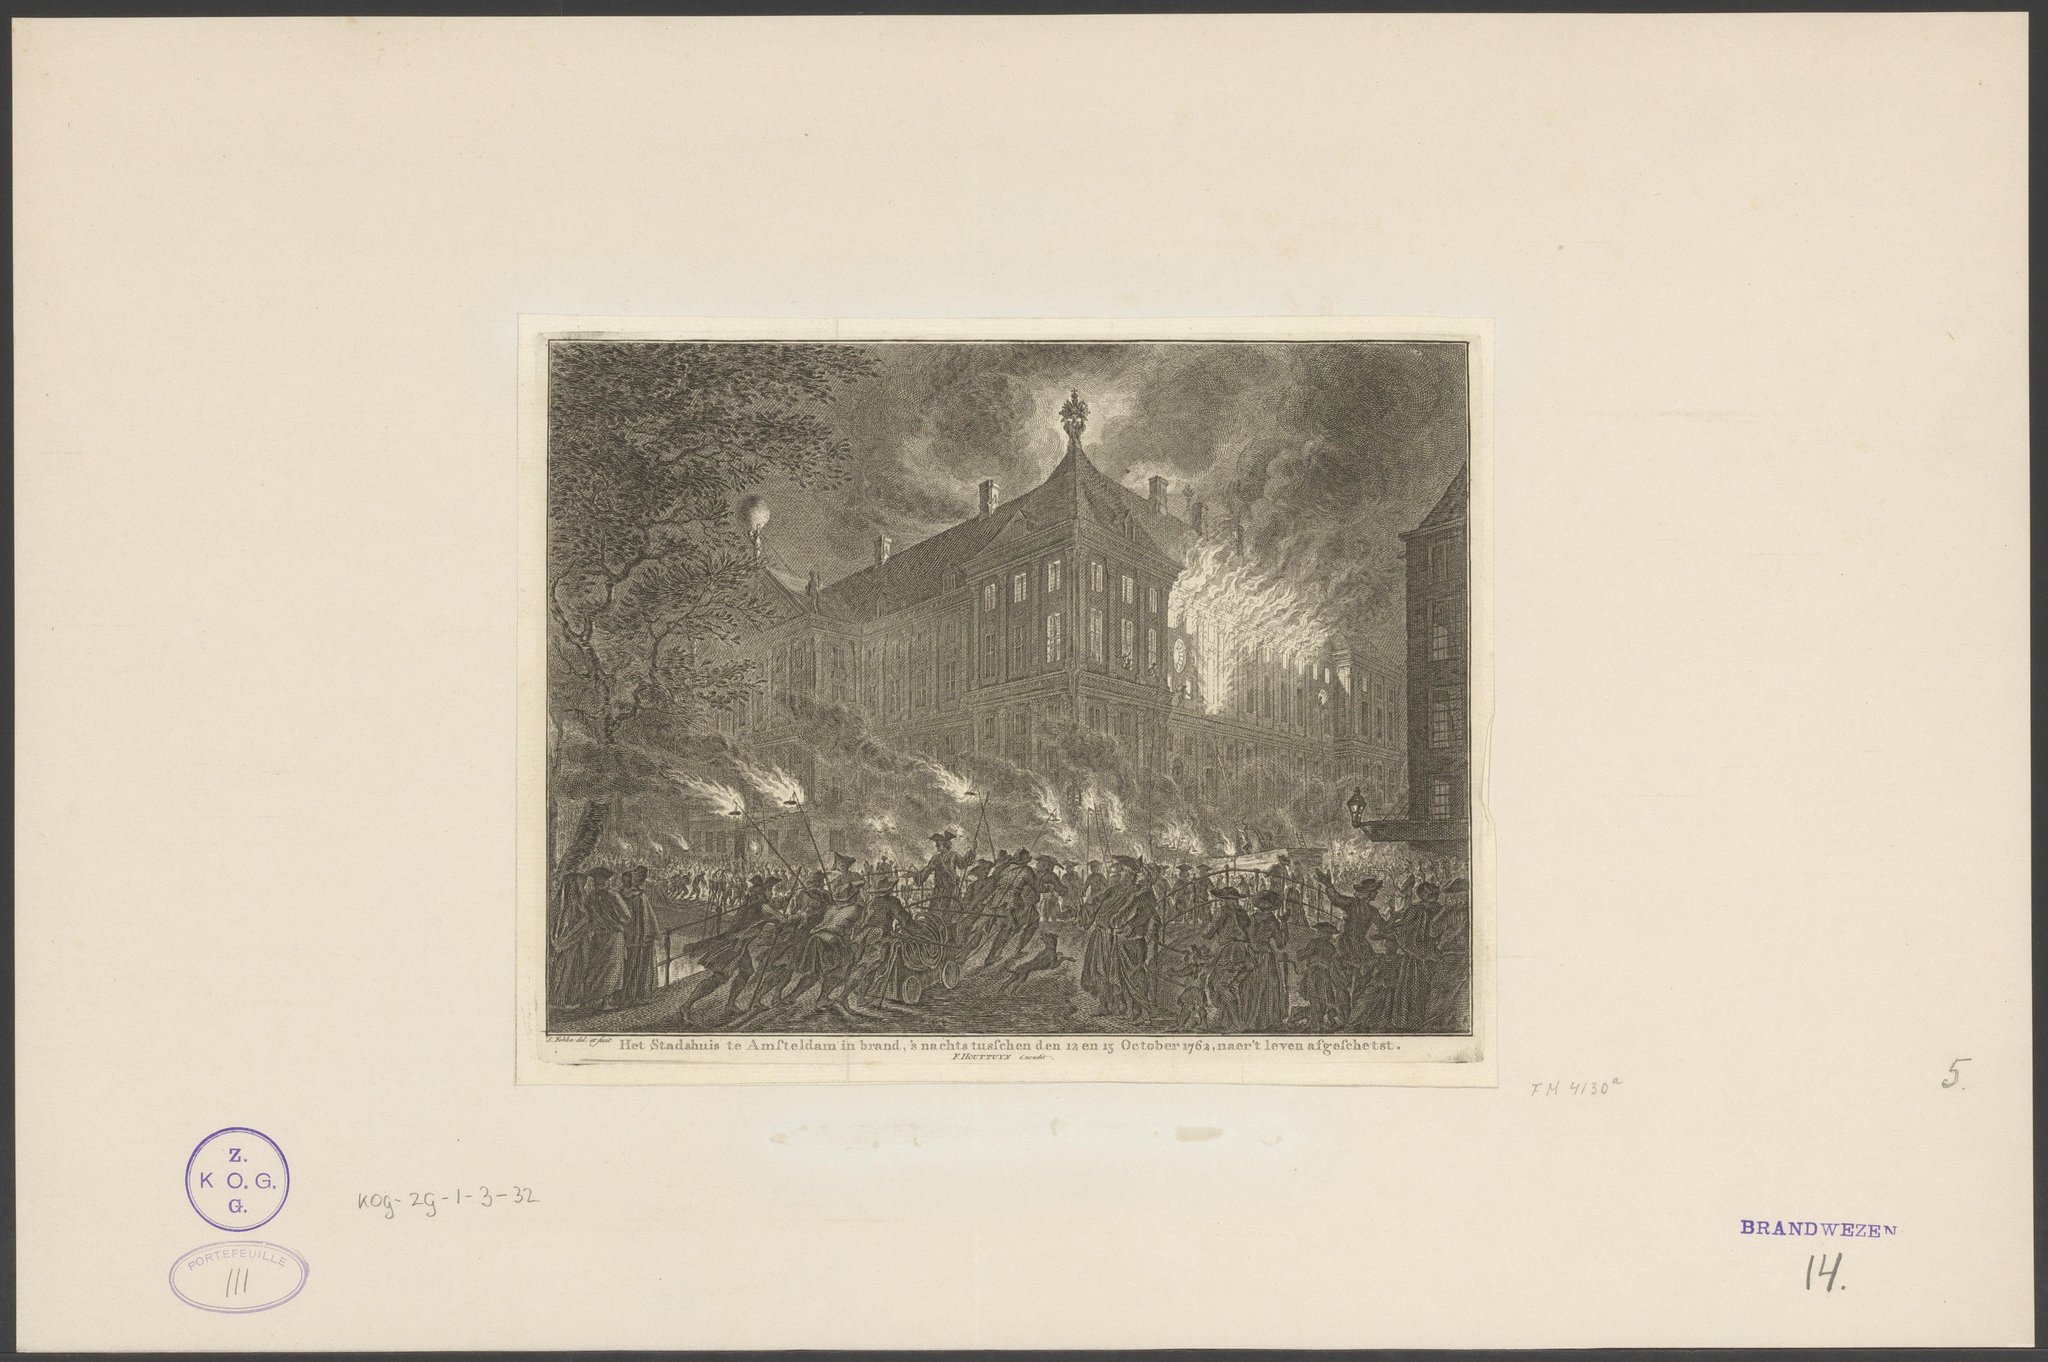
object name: print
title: Het Stadshuis te Amsteldam in brand, 's nachts tusschen den 12 en 13 October 1762, naer 't leven afgeschetst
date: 1762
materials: paper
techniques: engraving, etching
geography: amsterdam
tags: on fire, ablaze, townhall, fire-fighting, fire-extinguishing equipment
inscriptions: collector's mark: Lugt 1641, stamp, stamp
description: Prent mogelijk gebruikt in: Nederlandsche Jaerboeken, inhoudende een verhael van de merkwaerdigste geschiedenissen (…). Amsterdam: Frans Houttuyn, s.a. [1762-1763], dl. 16.